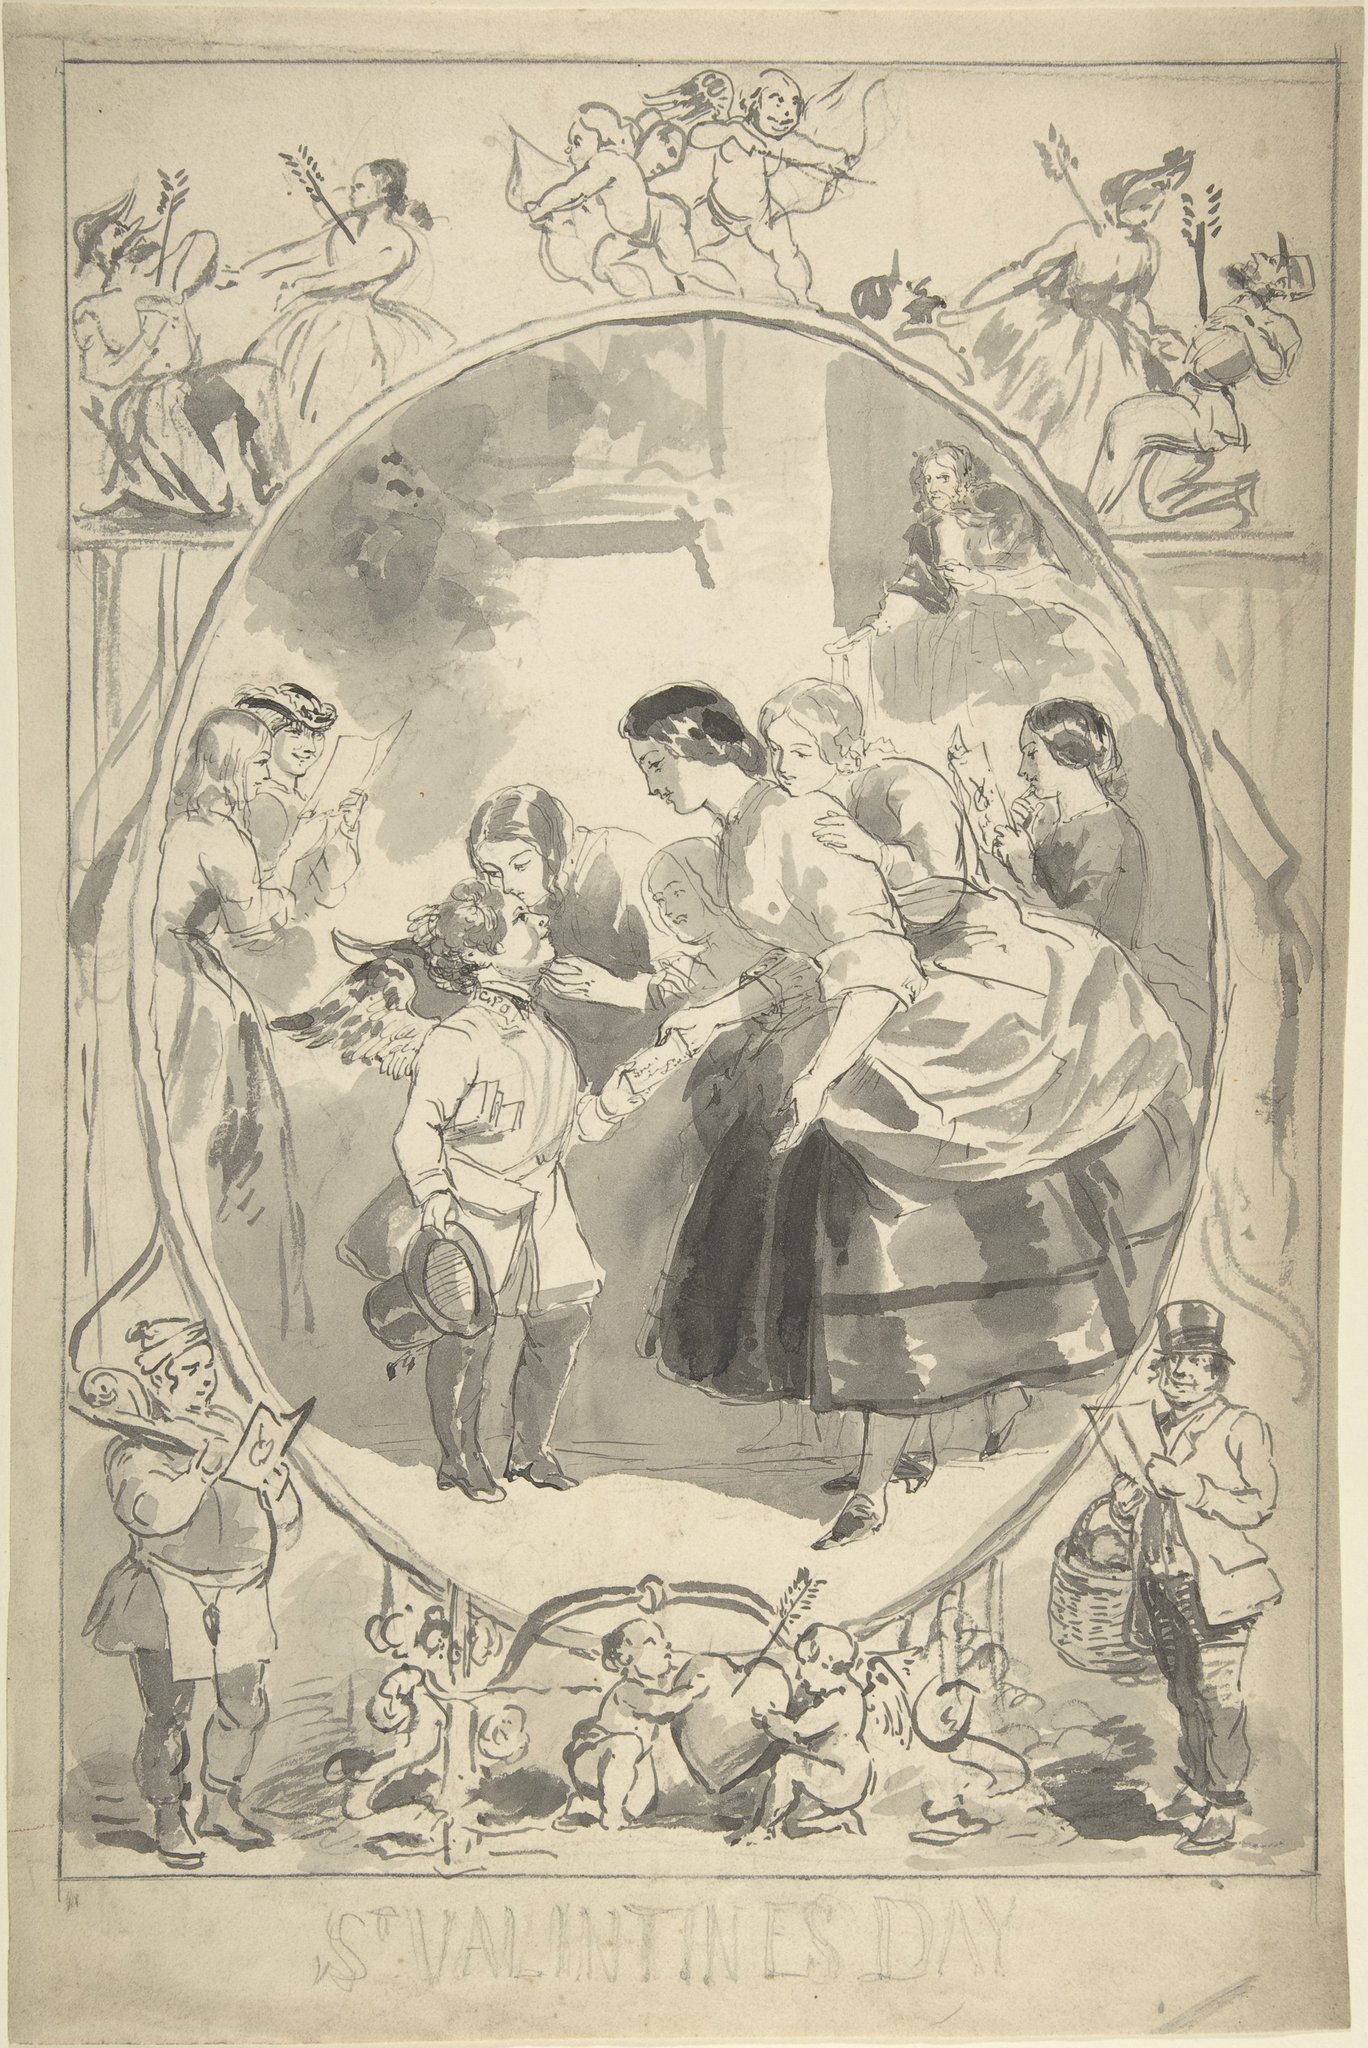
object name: drawing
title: Design for the Cover of a Magazine, Valentine's Day Issue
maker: anonymous, british, 19th century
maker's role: artist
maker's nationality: british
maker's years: 1800-1900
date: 1860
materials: graphite, ink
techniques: brush, pen, wash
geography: england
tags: men,women,cupid